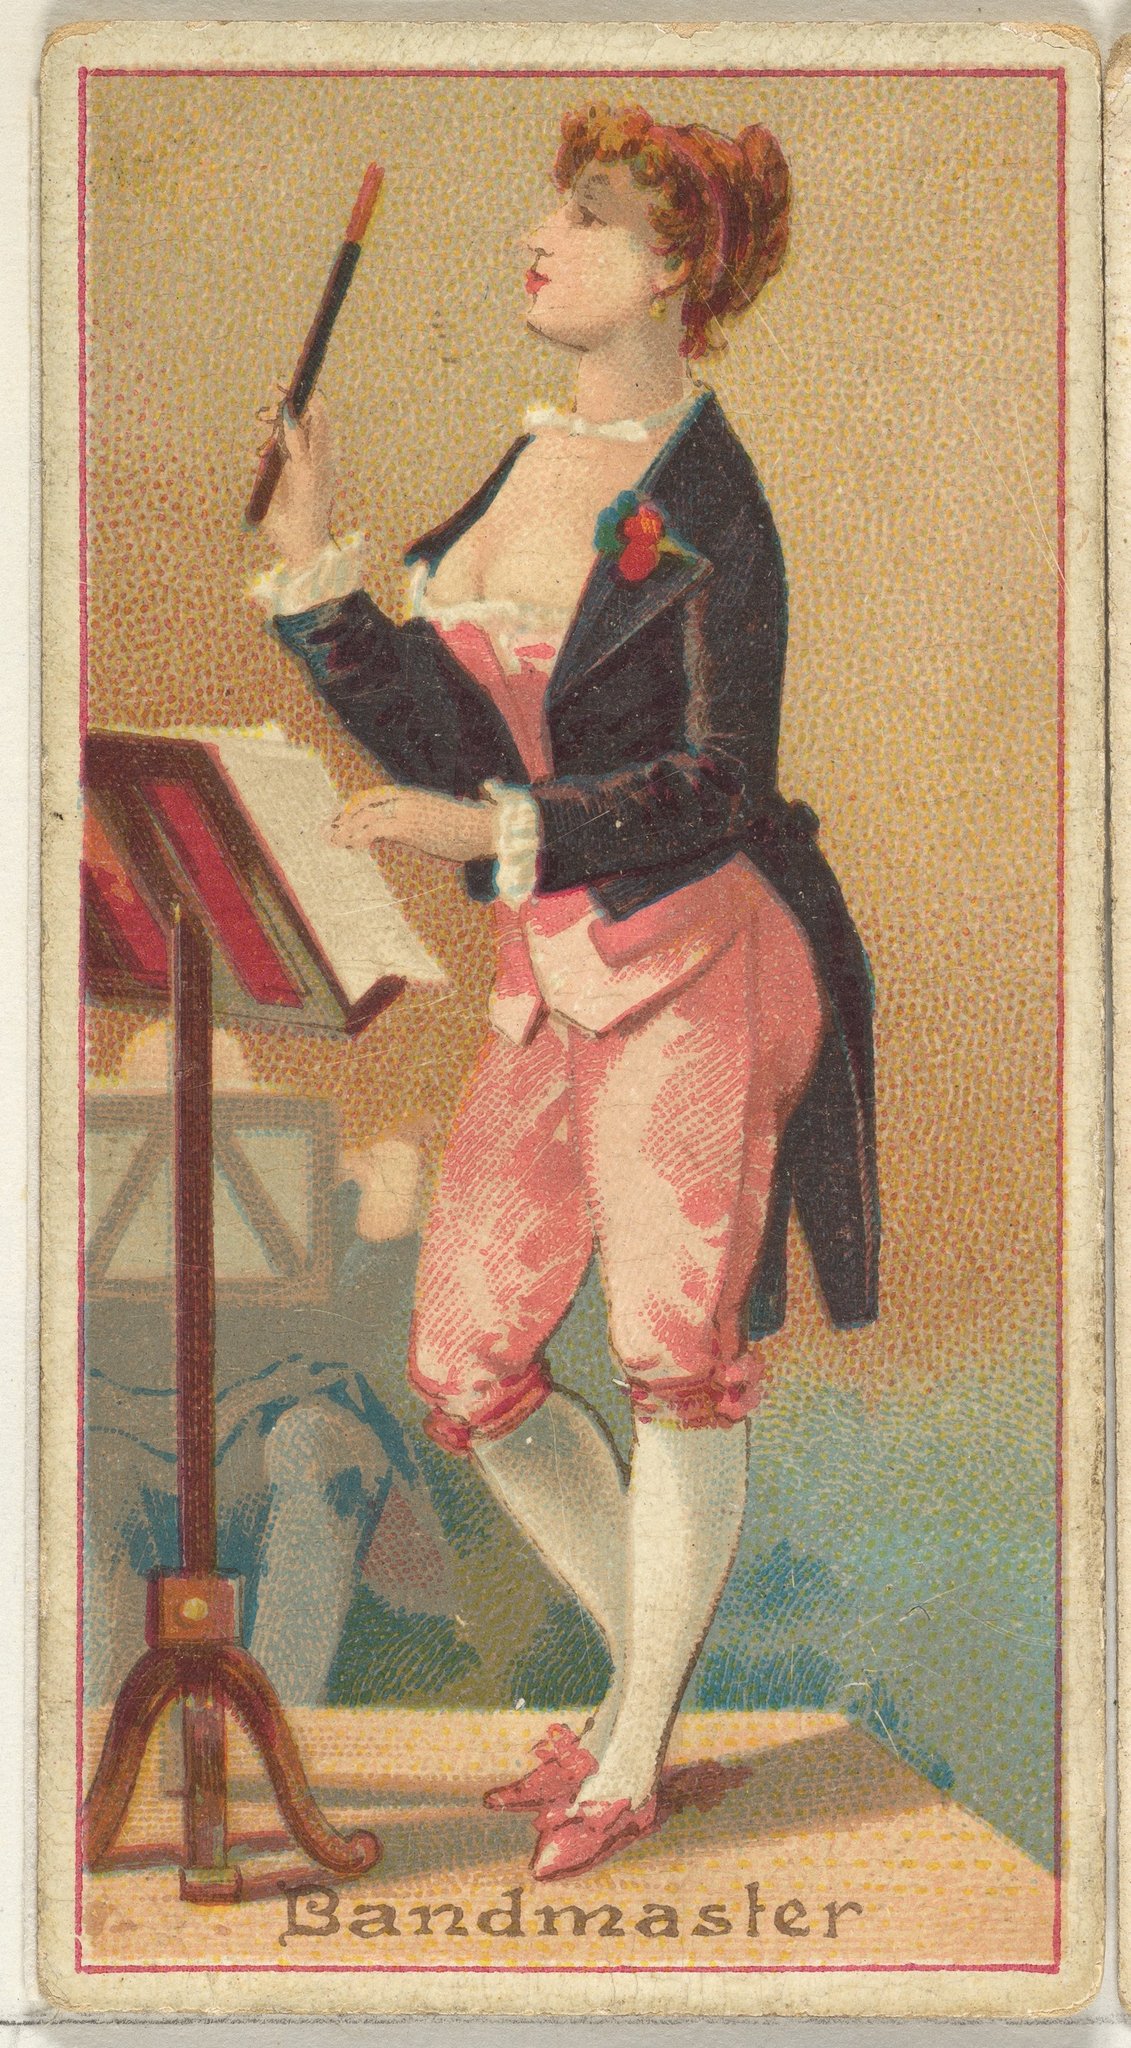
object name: print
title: Bandmaster, from the Occupations of Women series (N502) for Frishmuth's Tobacco Company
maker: frishmuth's tobacco company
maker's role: publisher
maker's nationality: american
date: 1889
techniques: color lithograph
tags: women,musicians,furniture